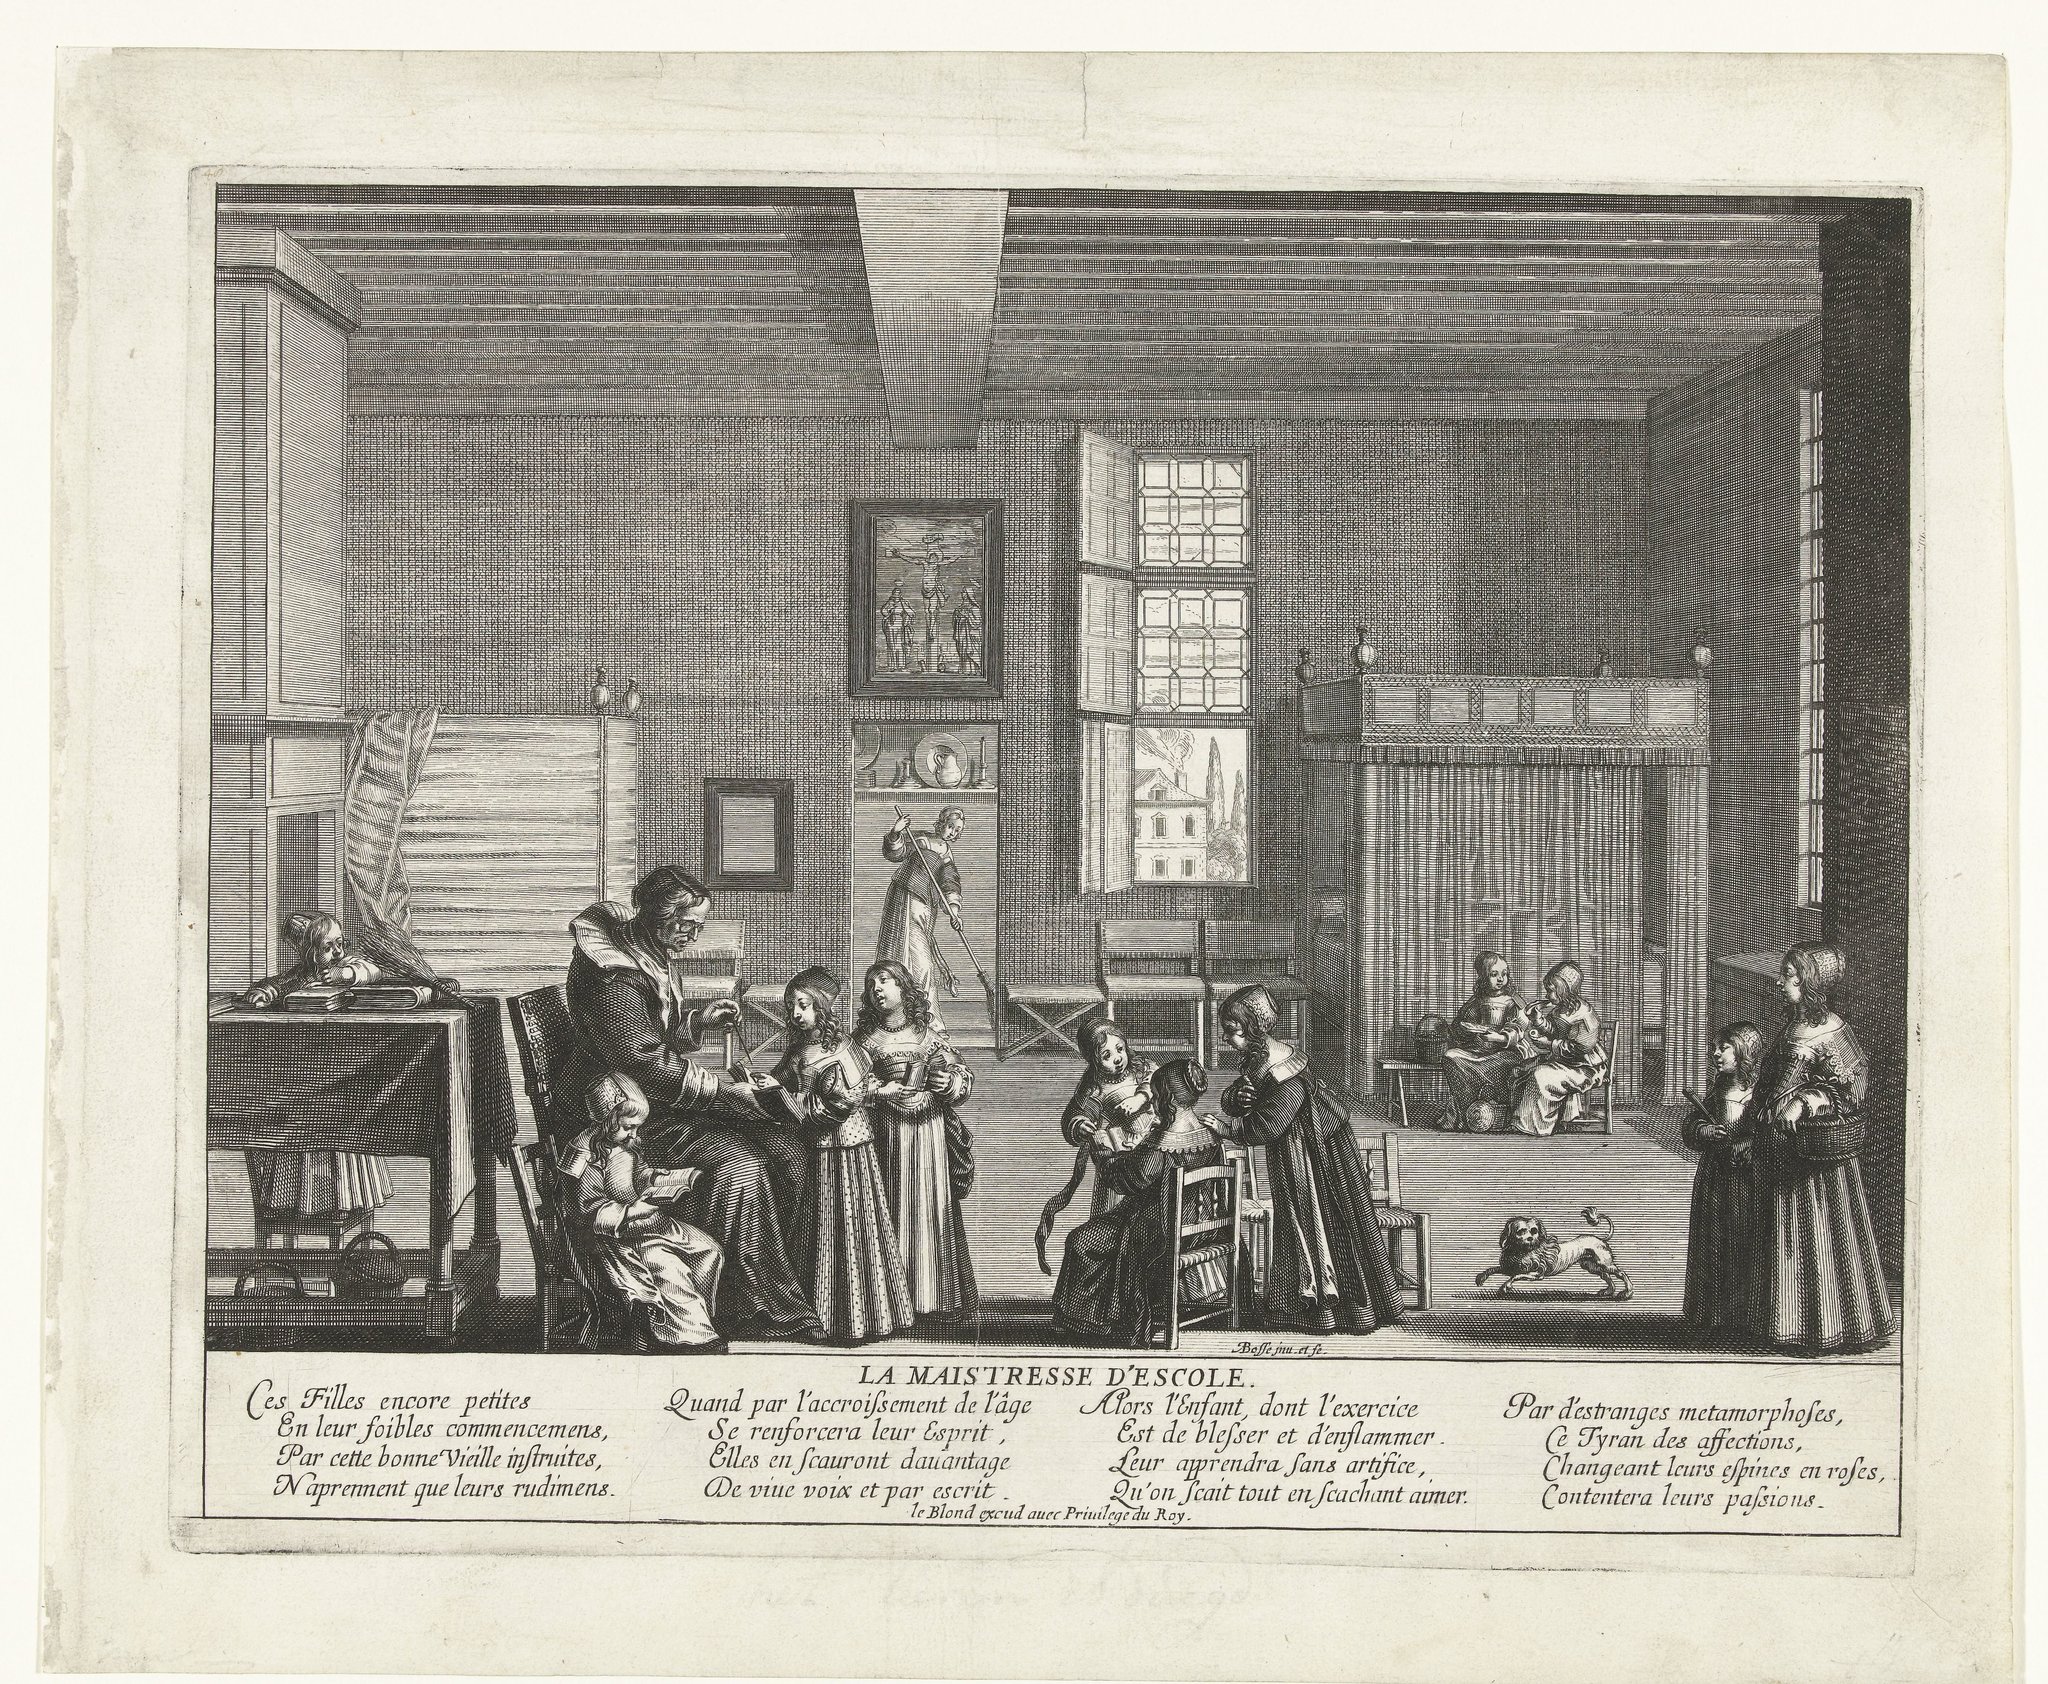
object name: print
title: La Maistresse de l'Escole.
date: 1638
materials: paper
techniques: engraving, etching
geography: france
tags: teacher and pupil, scholastic education, tuition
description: Een schoolvertrek waarin een schooljuffrouw aan meisjes onderwijs geeft. Op de achtergrond spelende meisjes en een meid die de vloer veegt. In het onderschrift 4 verzen van elk 4 regels in het Frans.